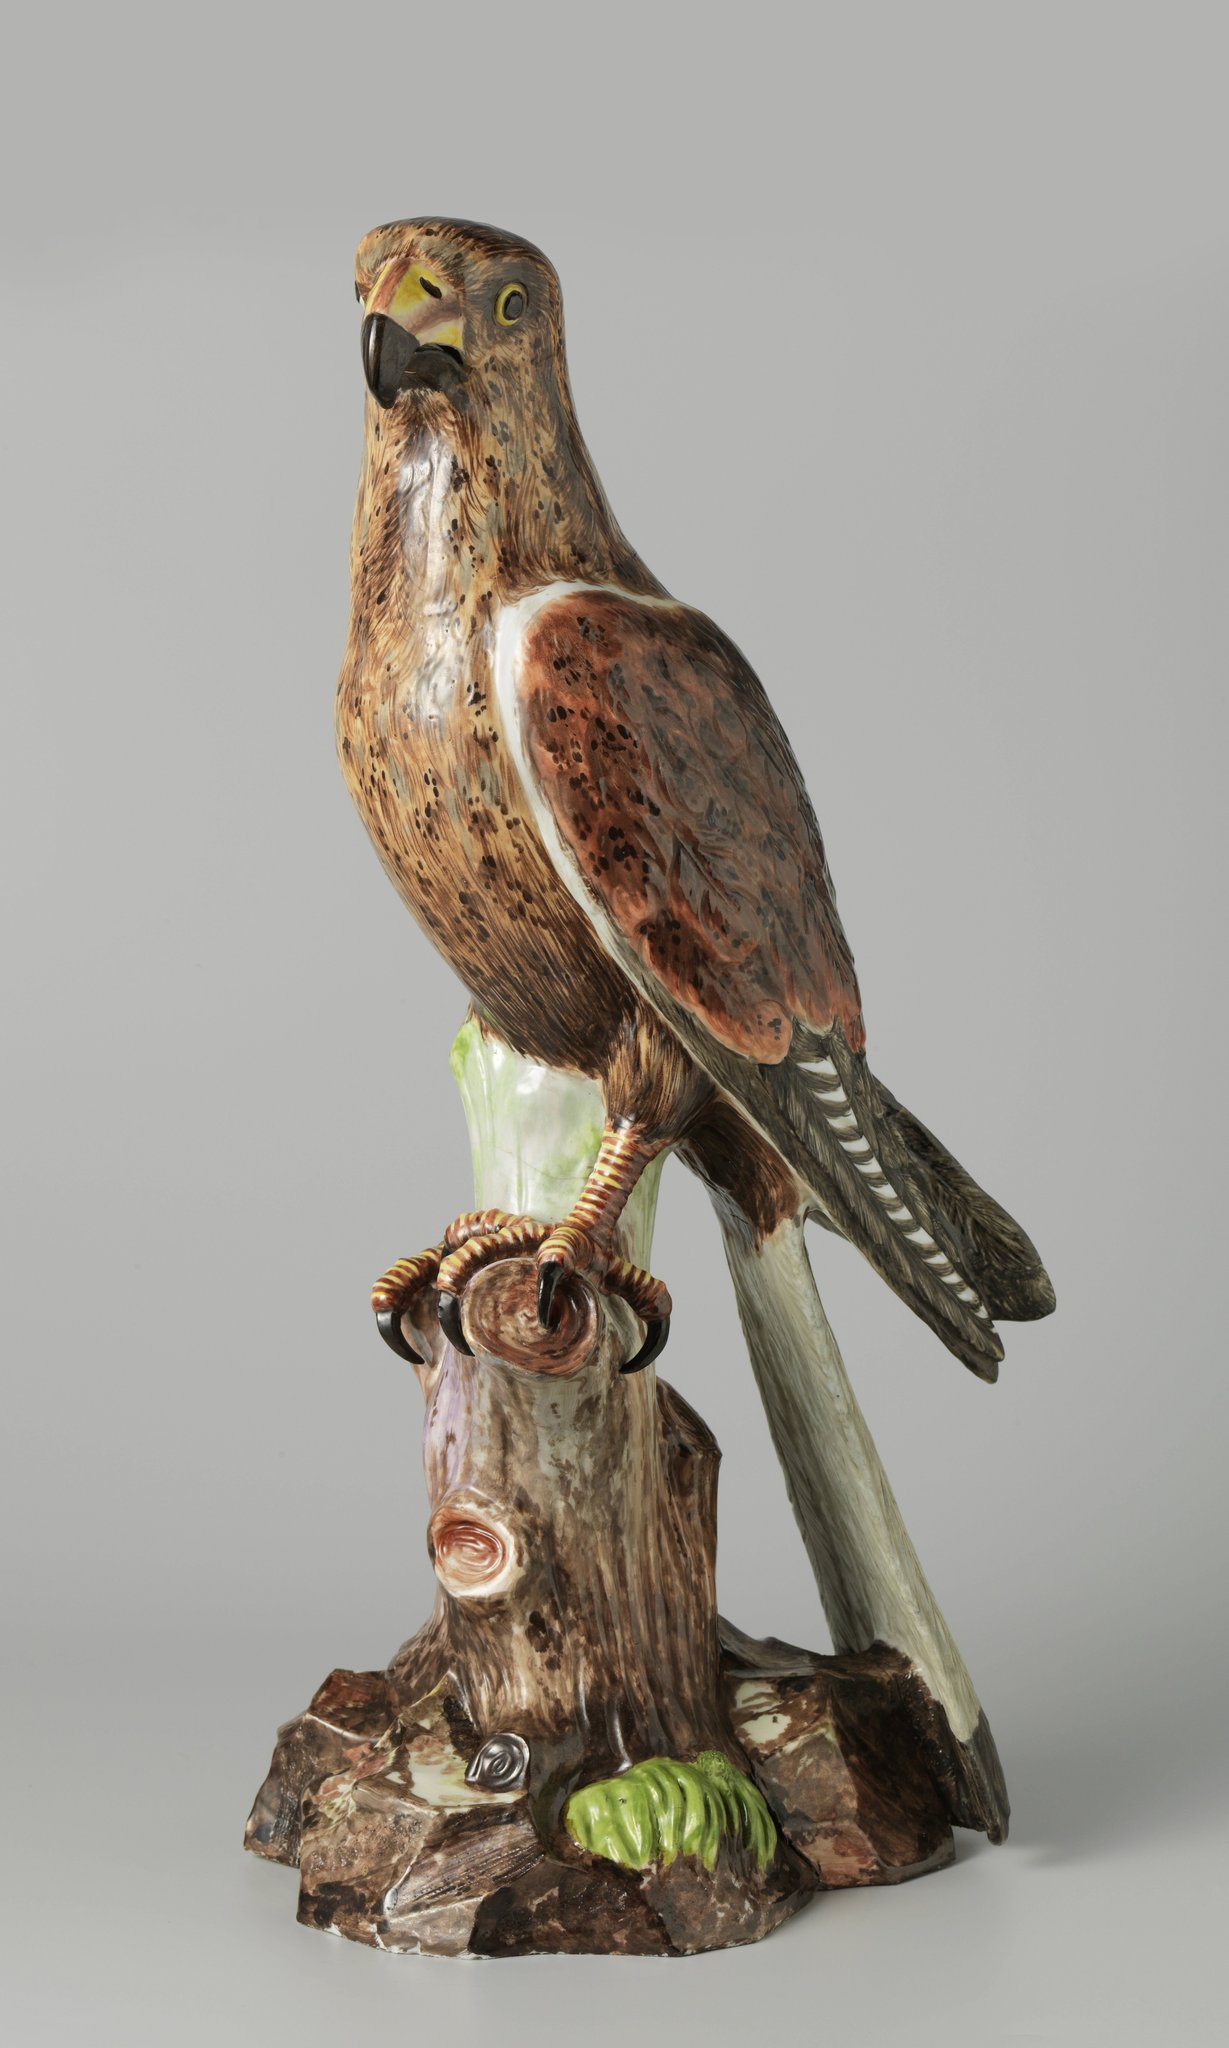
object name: figure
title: Valk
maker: johann joachim kändler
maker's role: designer, sculptor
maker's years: 1706-1775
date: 1731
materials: porcelain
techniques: painted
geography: meissen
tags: predatory birds: falcon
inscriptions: factory mark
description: Falcon. Porcelain. Meissen, 1731, the model by Johann Joachim Kändler.